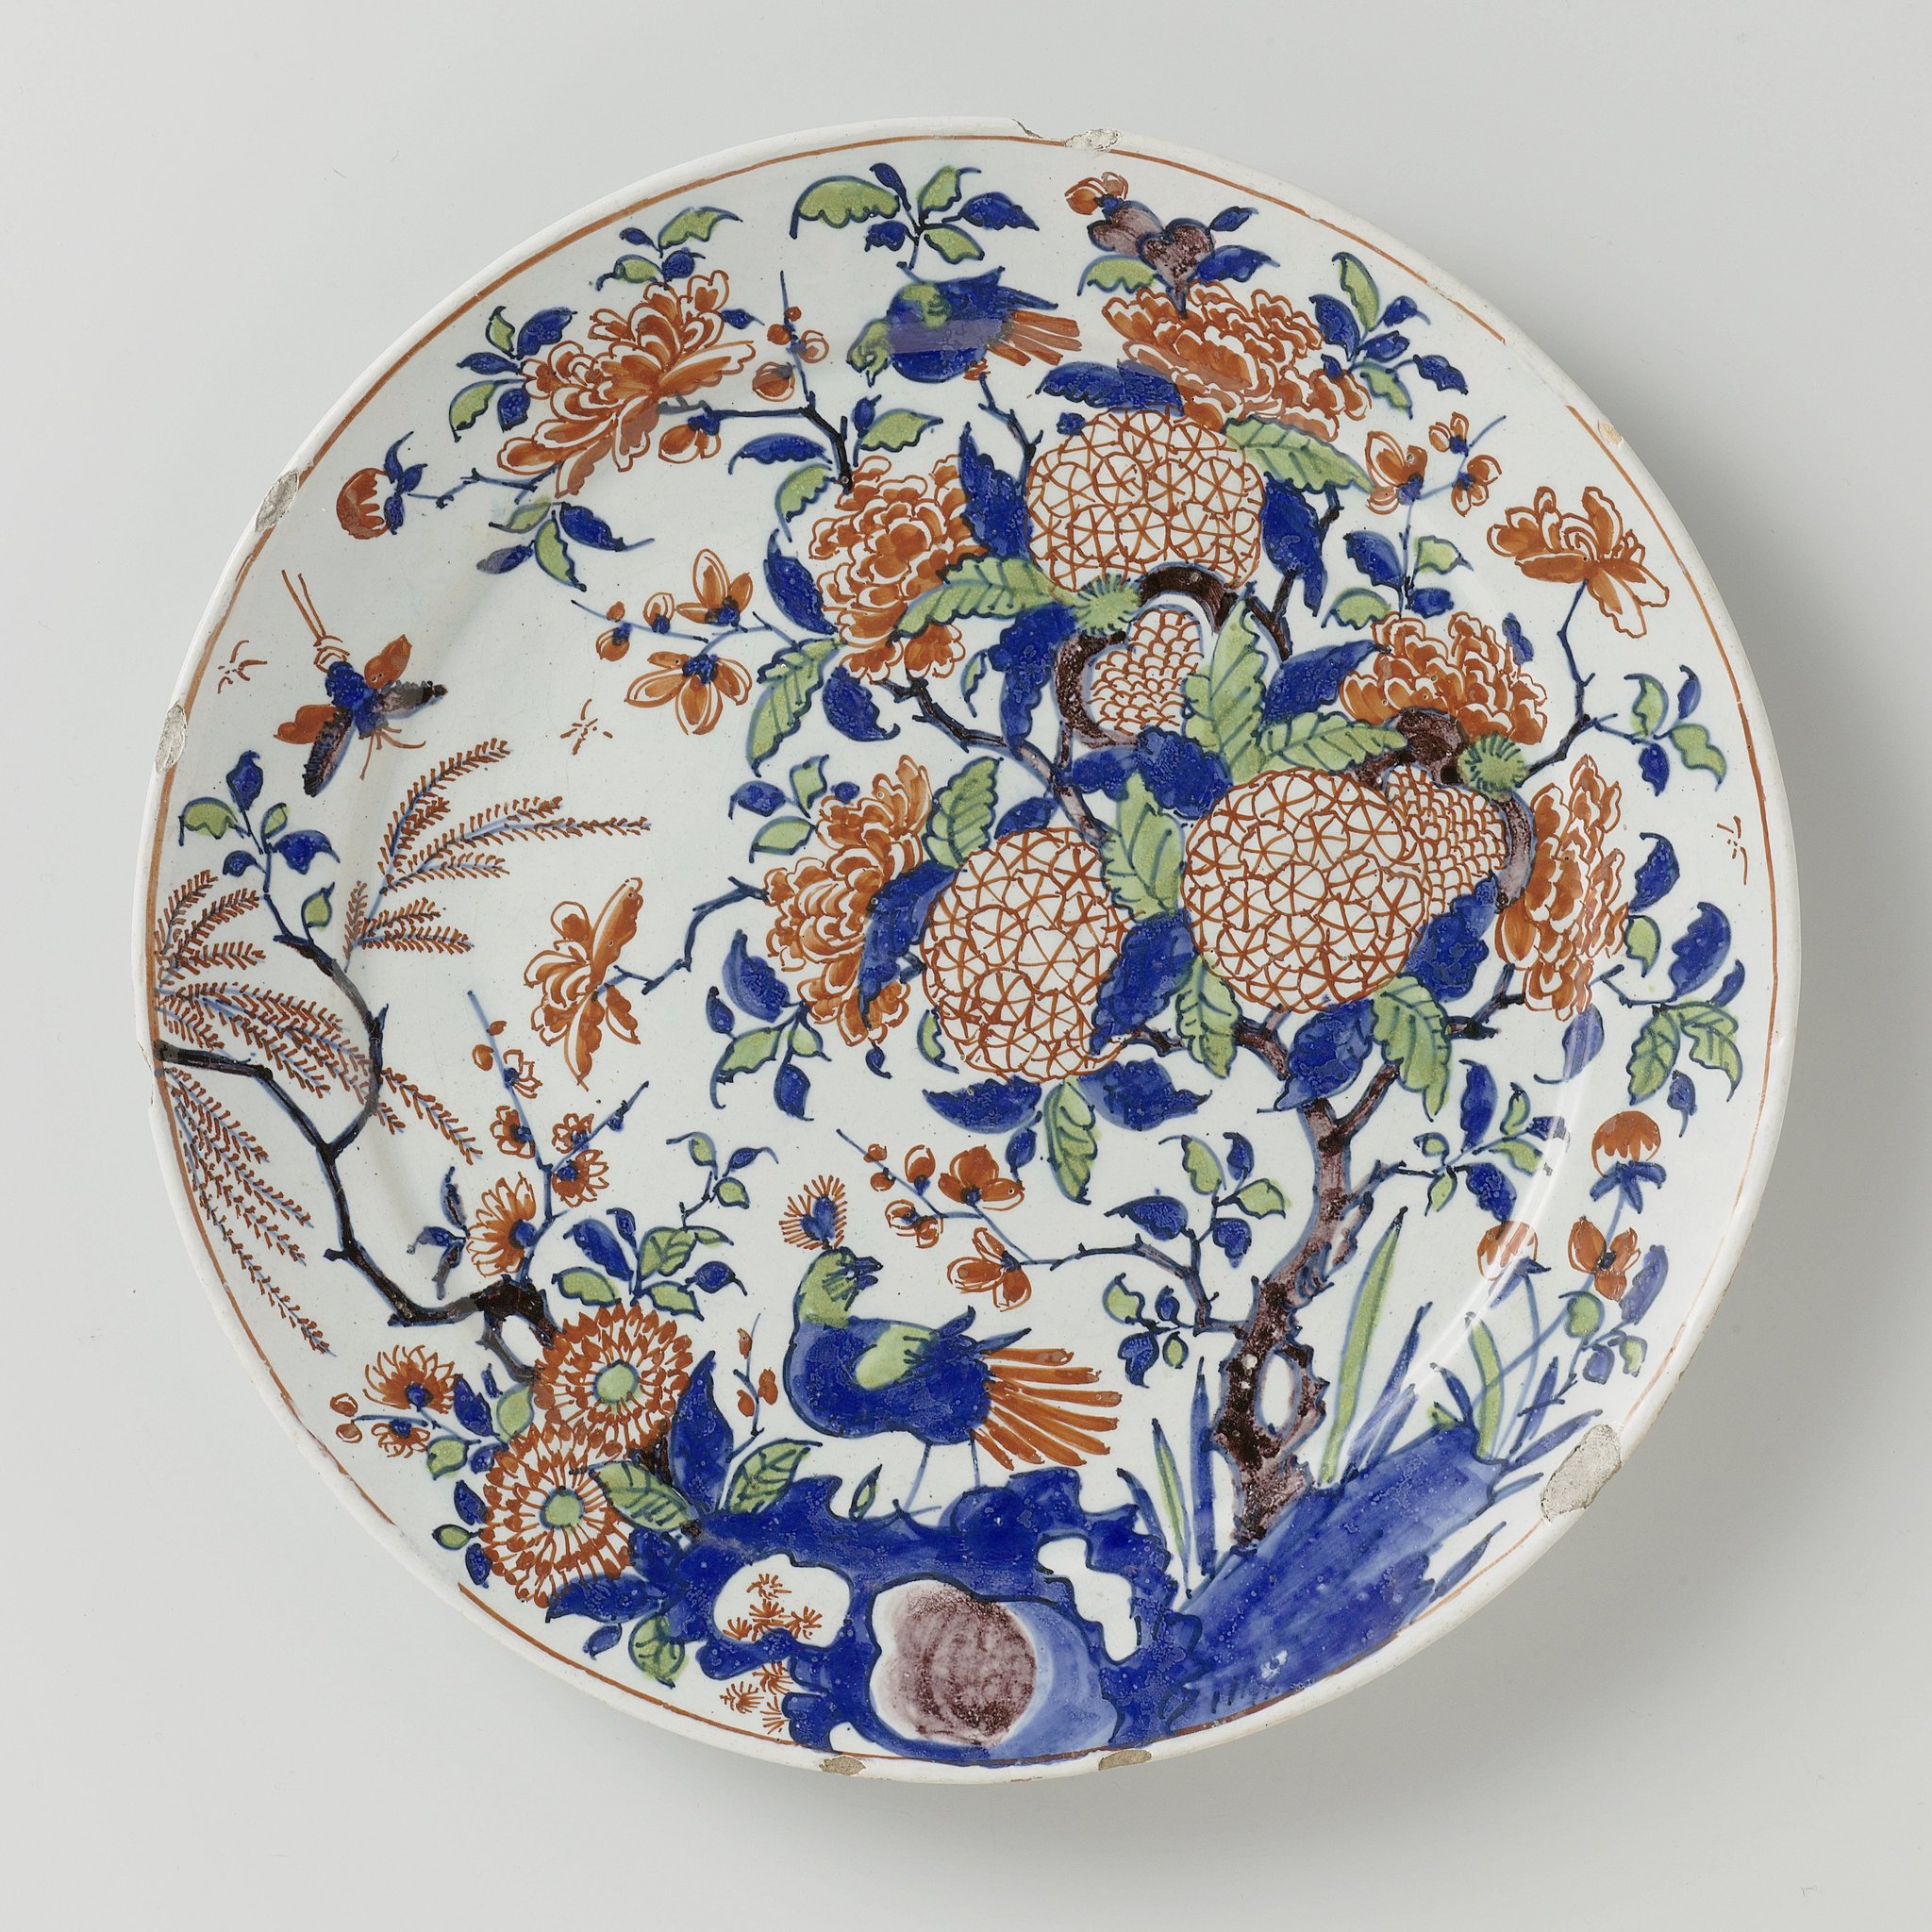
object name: plate dish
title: Bord met bloemversiering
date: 1695-1710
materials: earthenware, glaze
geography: delft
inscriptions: mark: ‘RooS’, collector's mark: ‘koninklijk oudheidkundig genootschap no. 8’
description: Bord, rond, van aardewerk, aan de voor- en achterzijde met witte tinglazuur gedekt. Voorzijde over het hele bord veelkleurig beschilderd met bloemen, plant en vogel. Op de achterzijde vier ranken. Gemerkt: ROOS.